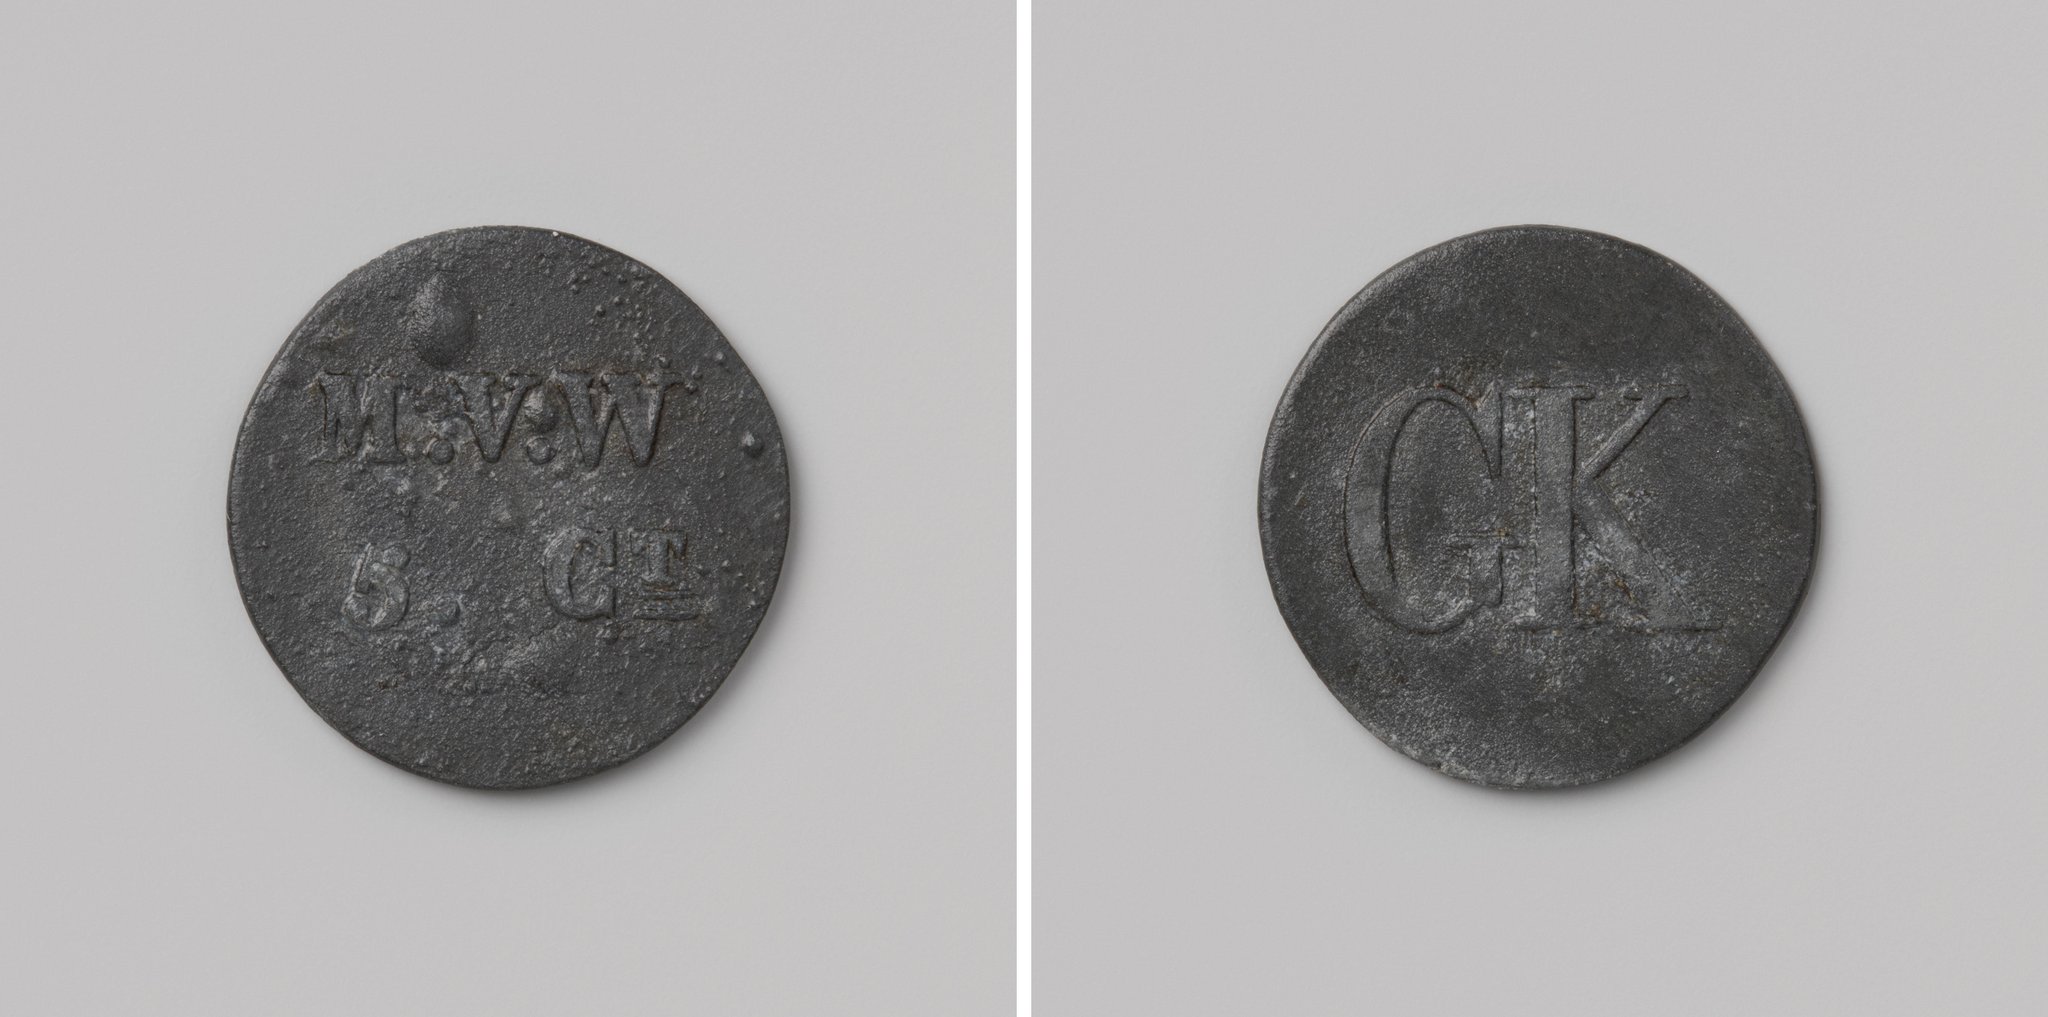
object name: vijf cent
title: Huismunt ter waarde van vijf cent, geslagen op last van de Maatschappij van Weldadigheid ten behoeve van de Gewone Koloniën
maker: Anonymous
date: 1818-1859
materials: zinc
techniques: striking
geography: netherlands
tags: maatschappij van weldadigheid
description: Zinken munt. Voorzijde: opschrift boven waardeaanduiding. Keerzijde: opschrift G en K.